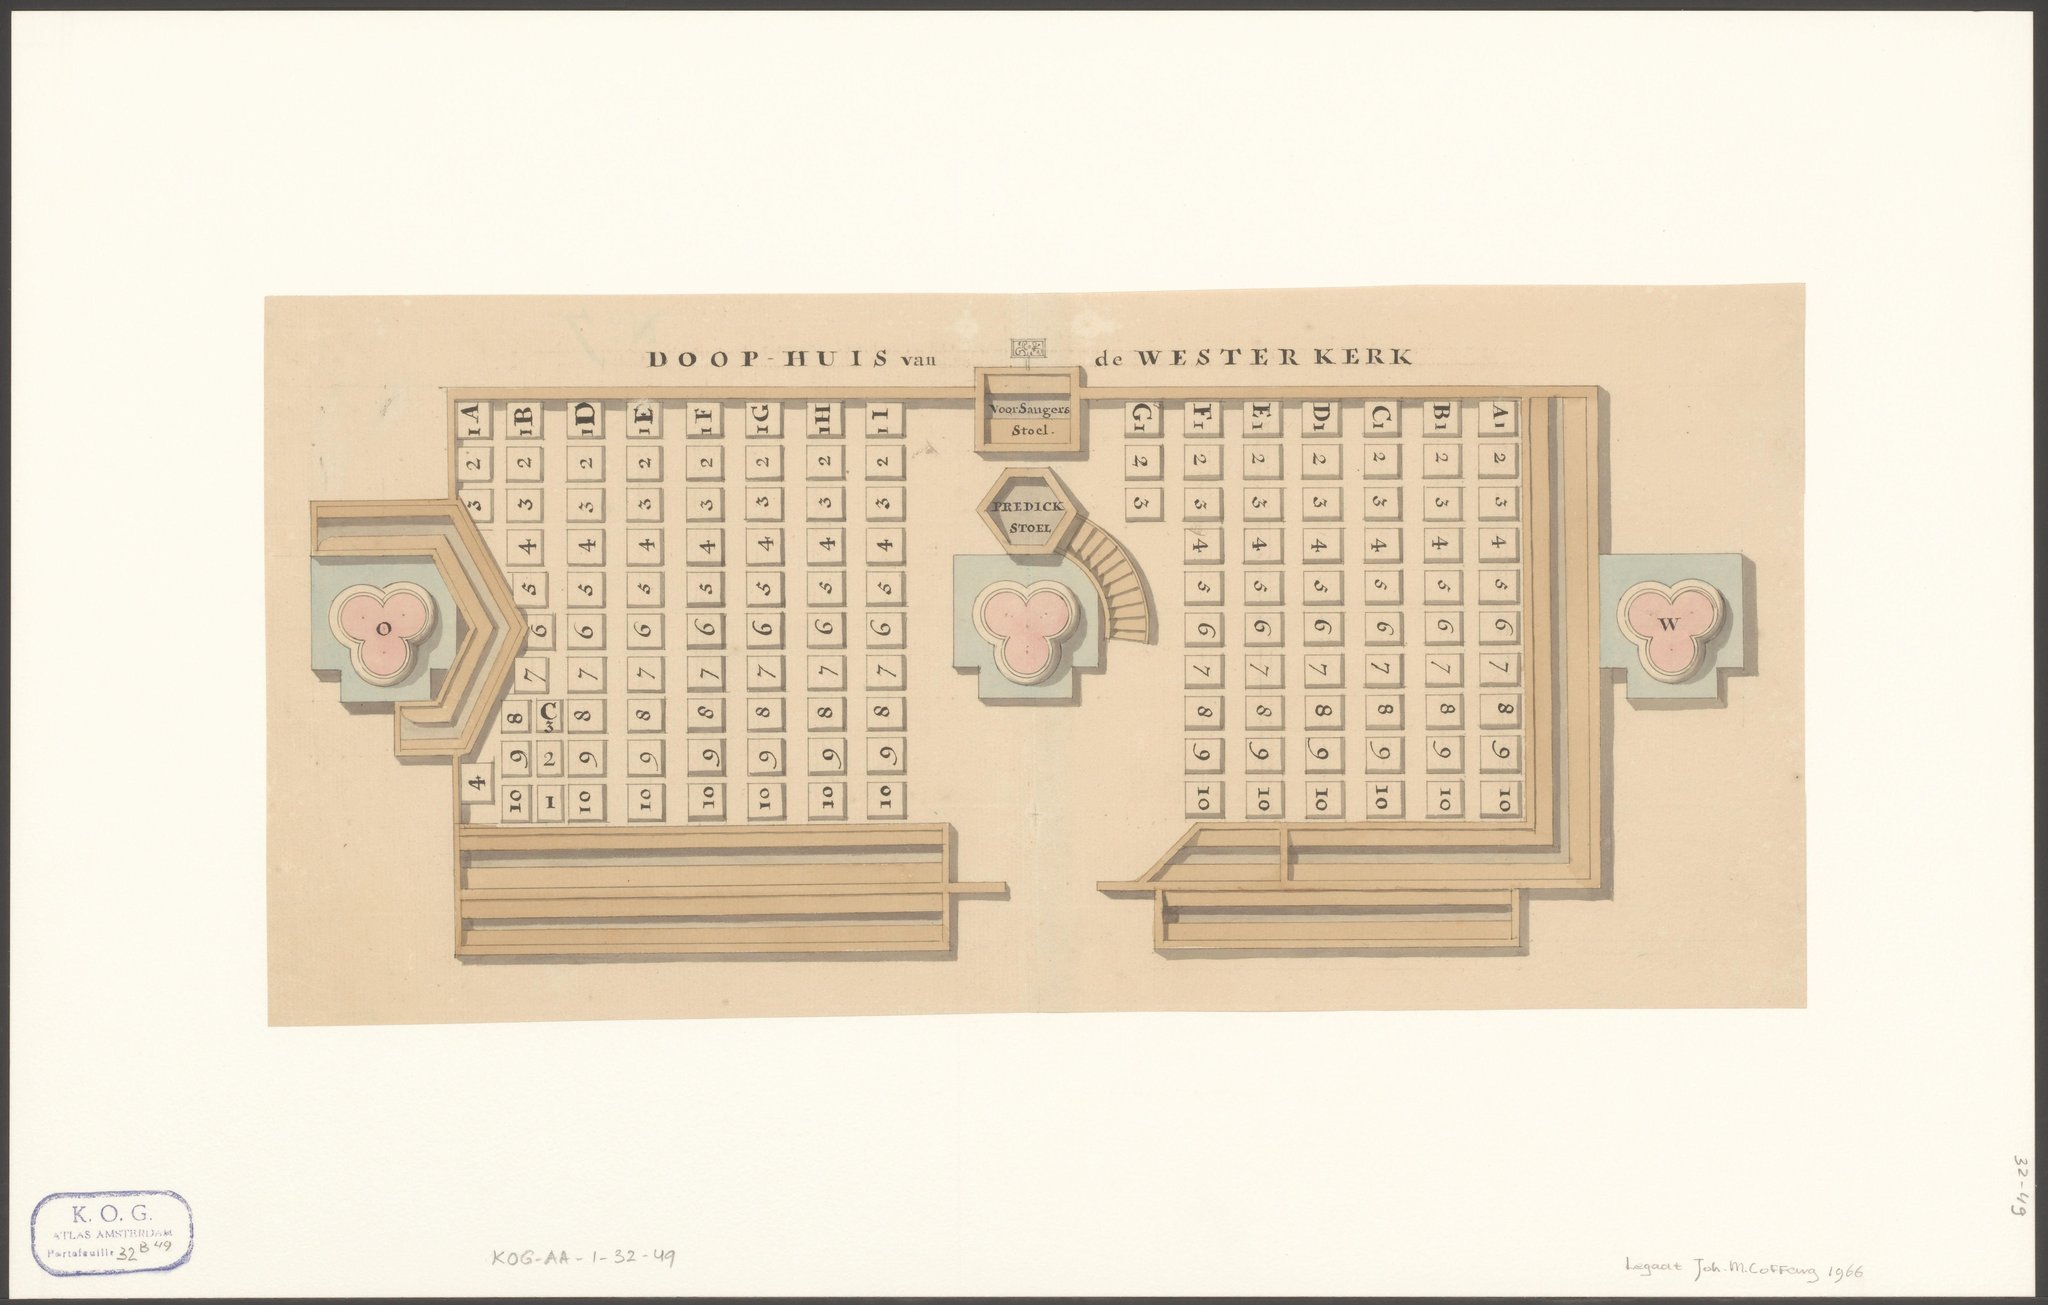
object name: drawing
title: Zitplaatsen van het baptisterium van de Westerkerk te Amsterdam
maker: Anonymous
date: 1750-1850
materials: paper, watercolor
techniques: brush, pen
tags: floor plan ~ architectural design or model, baptismal font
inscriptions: collector's mark: ‘32B49’ Lugt 1641b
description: Genummerd op verso: No. 7. Onderwerpsrubriek binnen de Atlas Amsterdam: Kerkwezen: Hervormde Gemeente: Westerkerk.